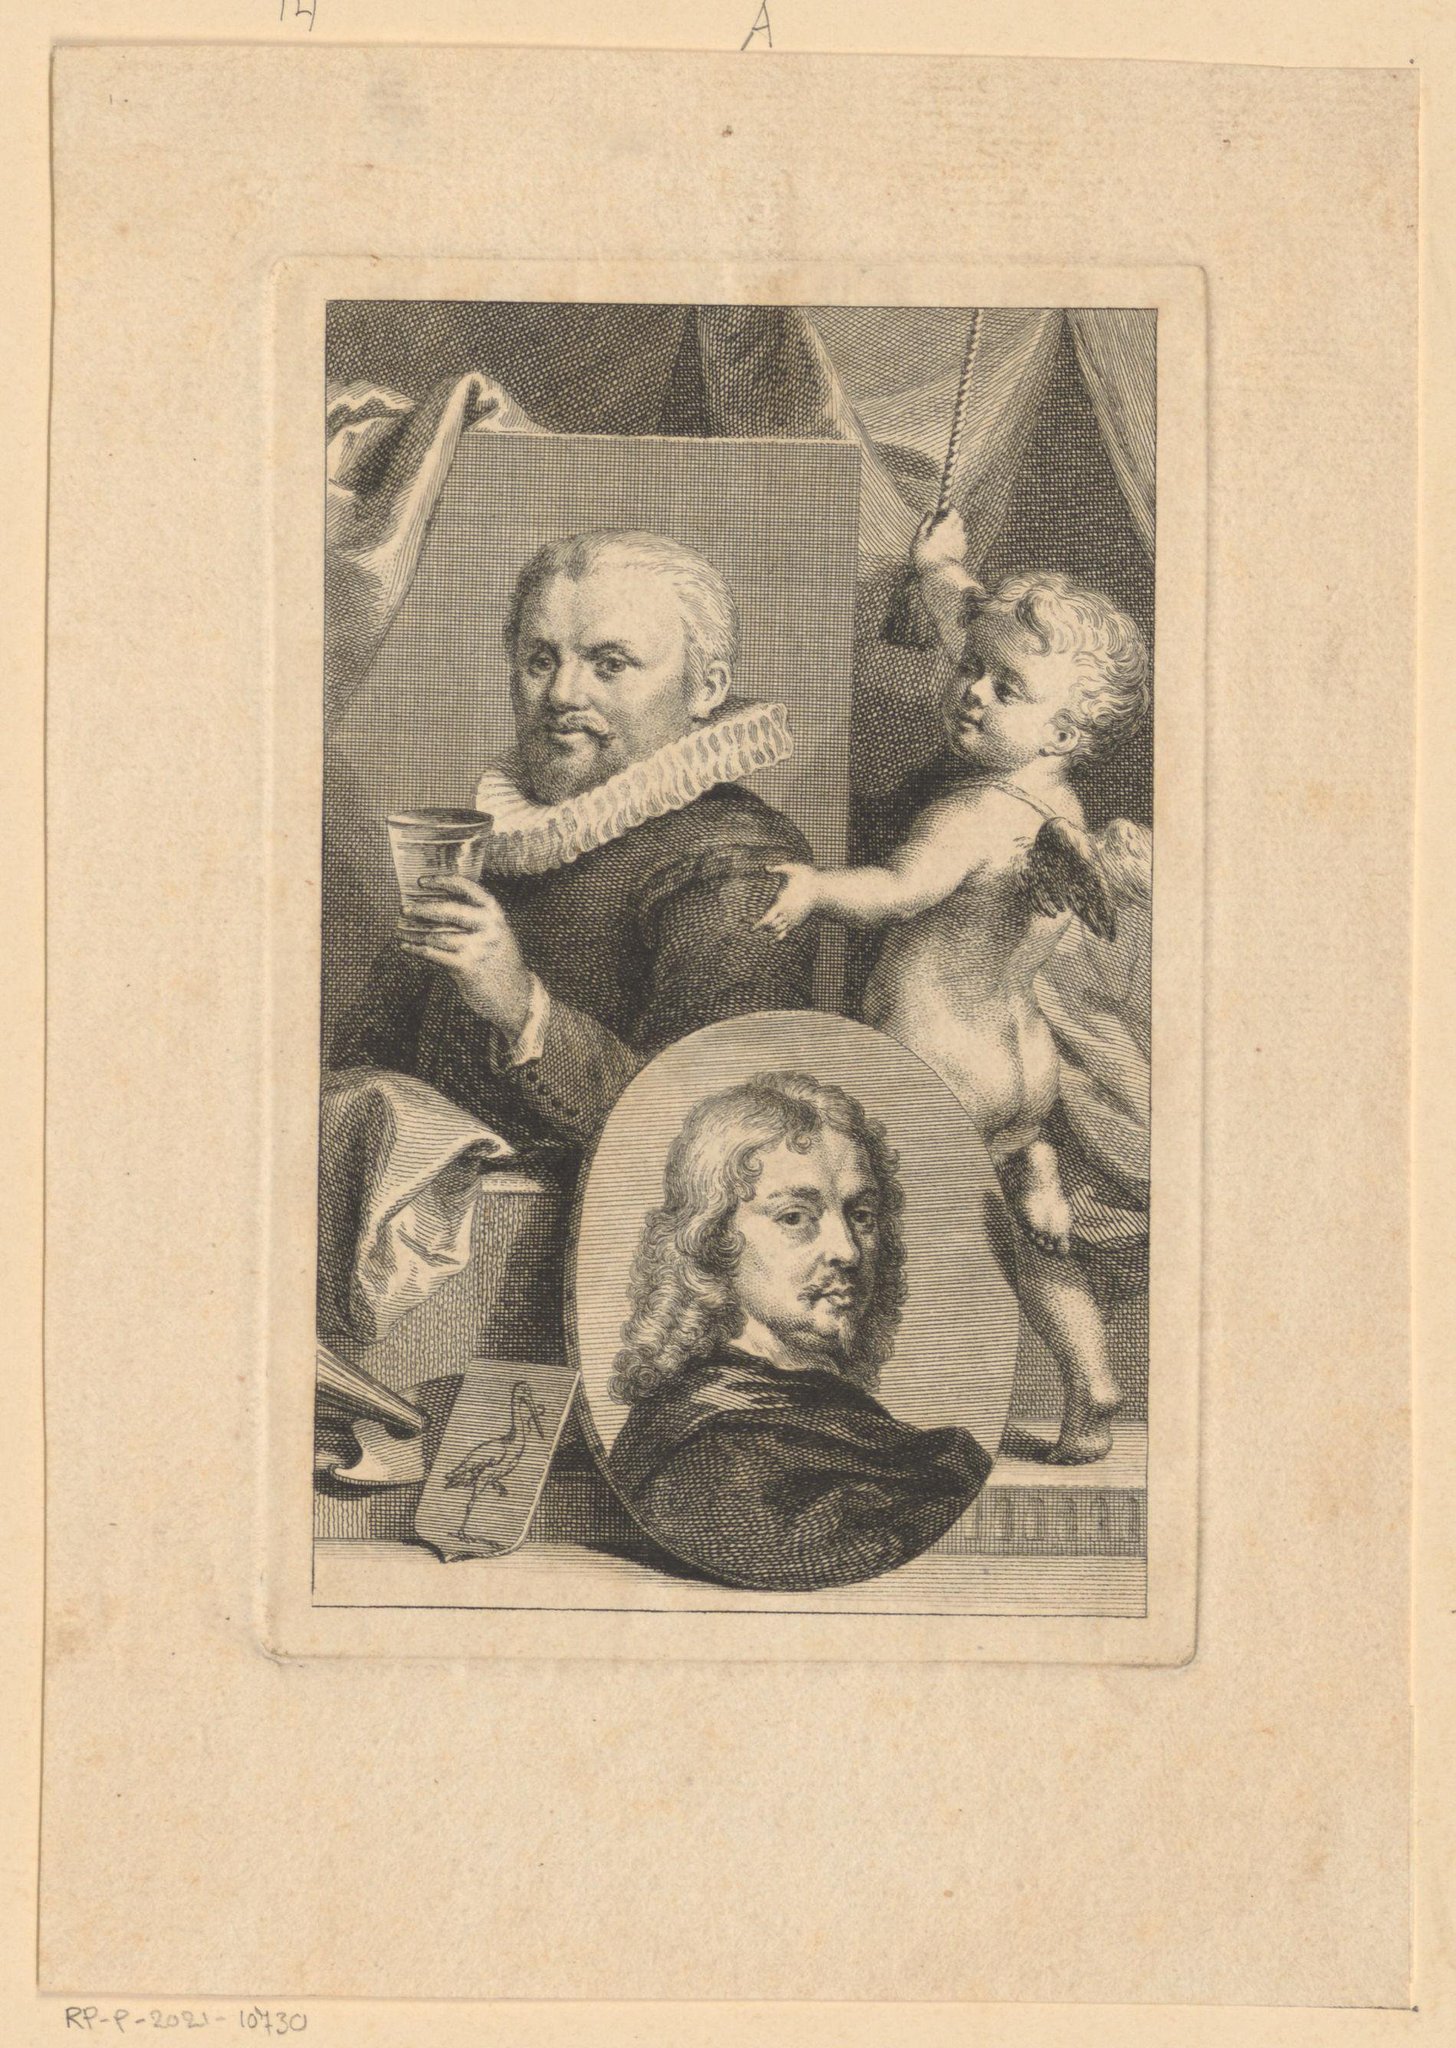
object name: print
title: Portretten van Jan Antonisz. van Ravesteyn en Adriaen Hanneman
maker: Anonymous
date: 1700-1799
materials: paper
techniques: engraving, etching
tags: adriaen hanneman, the hague, painter, draughtsman, jan antonisz van ravesteyn, historical persons, portrait, self-portrait of painter, armorial bearing, heraldry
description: Portretten van de schilders Jan Antonisz. van Ravesteyn en Adriaen Hanneman getoond door een putto. Linksonder het wapen van Den Haag, de stad waar de geportretteerde schilders werkzaam waren.